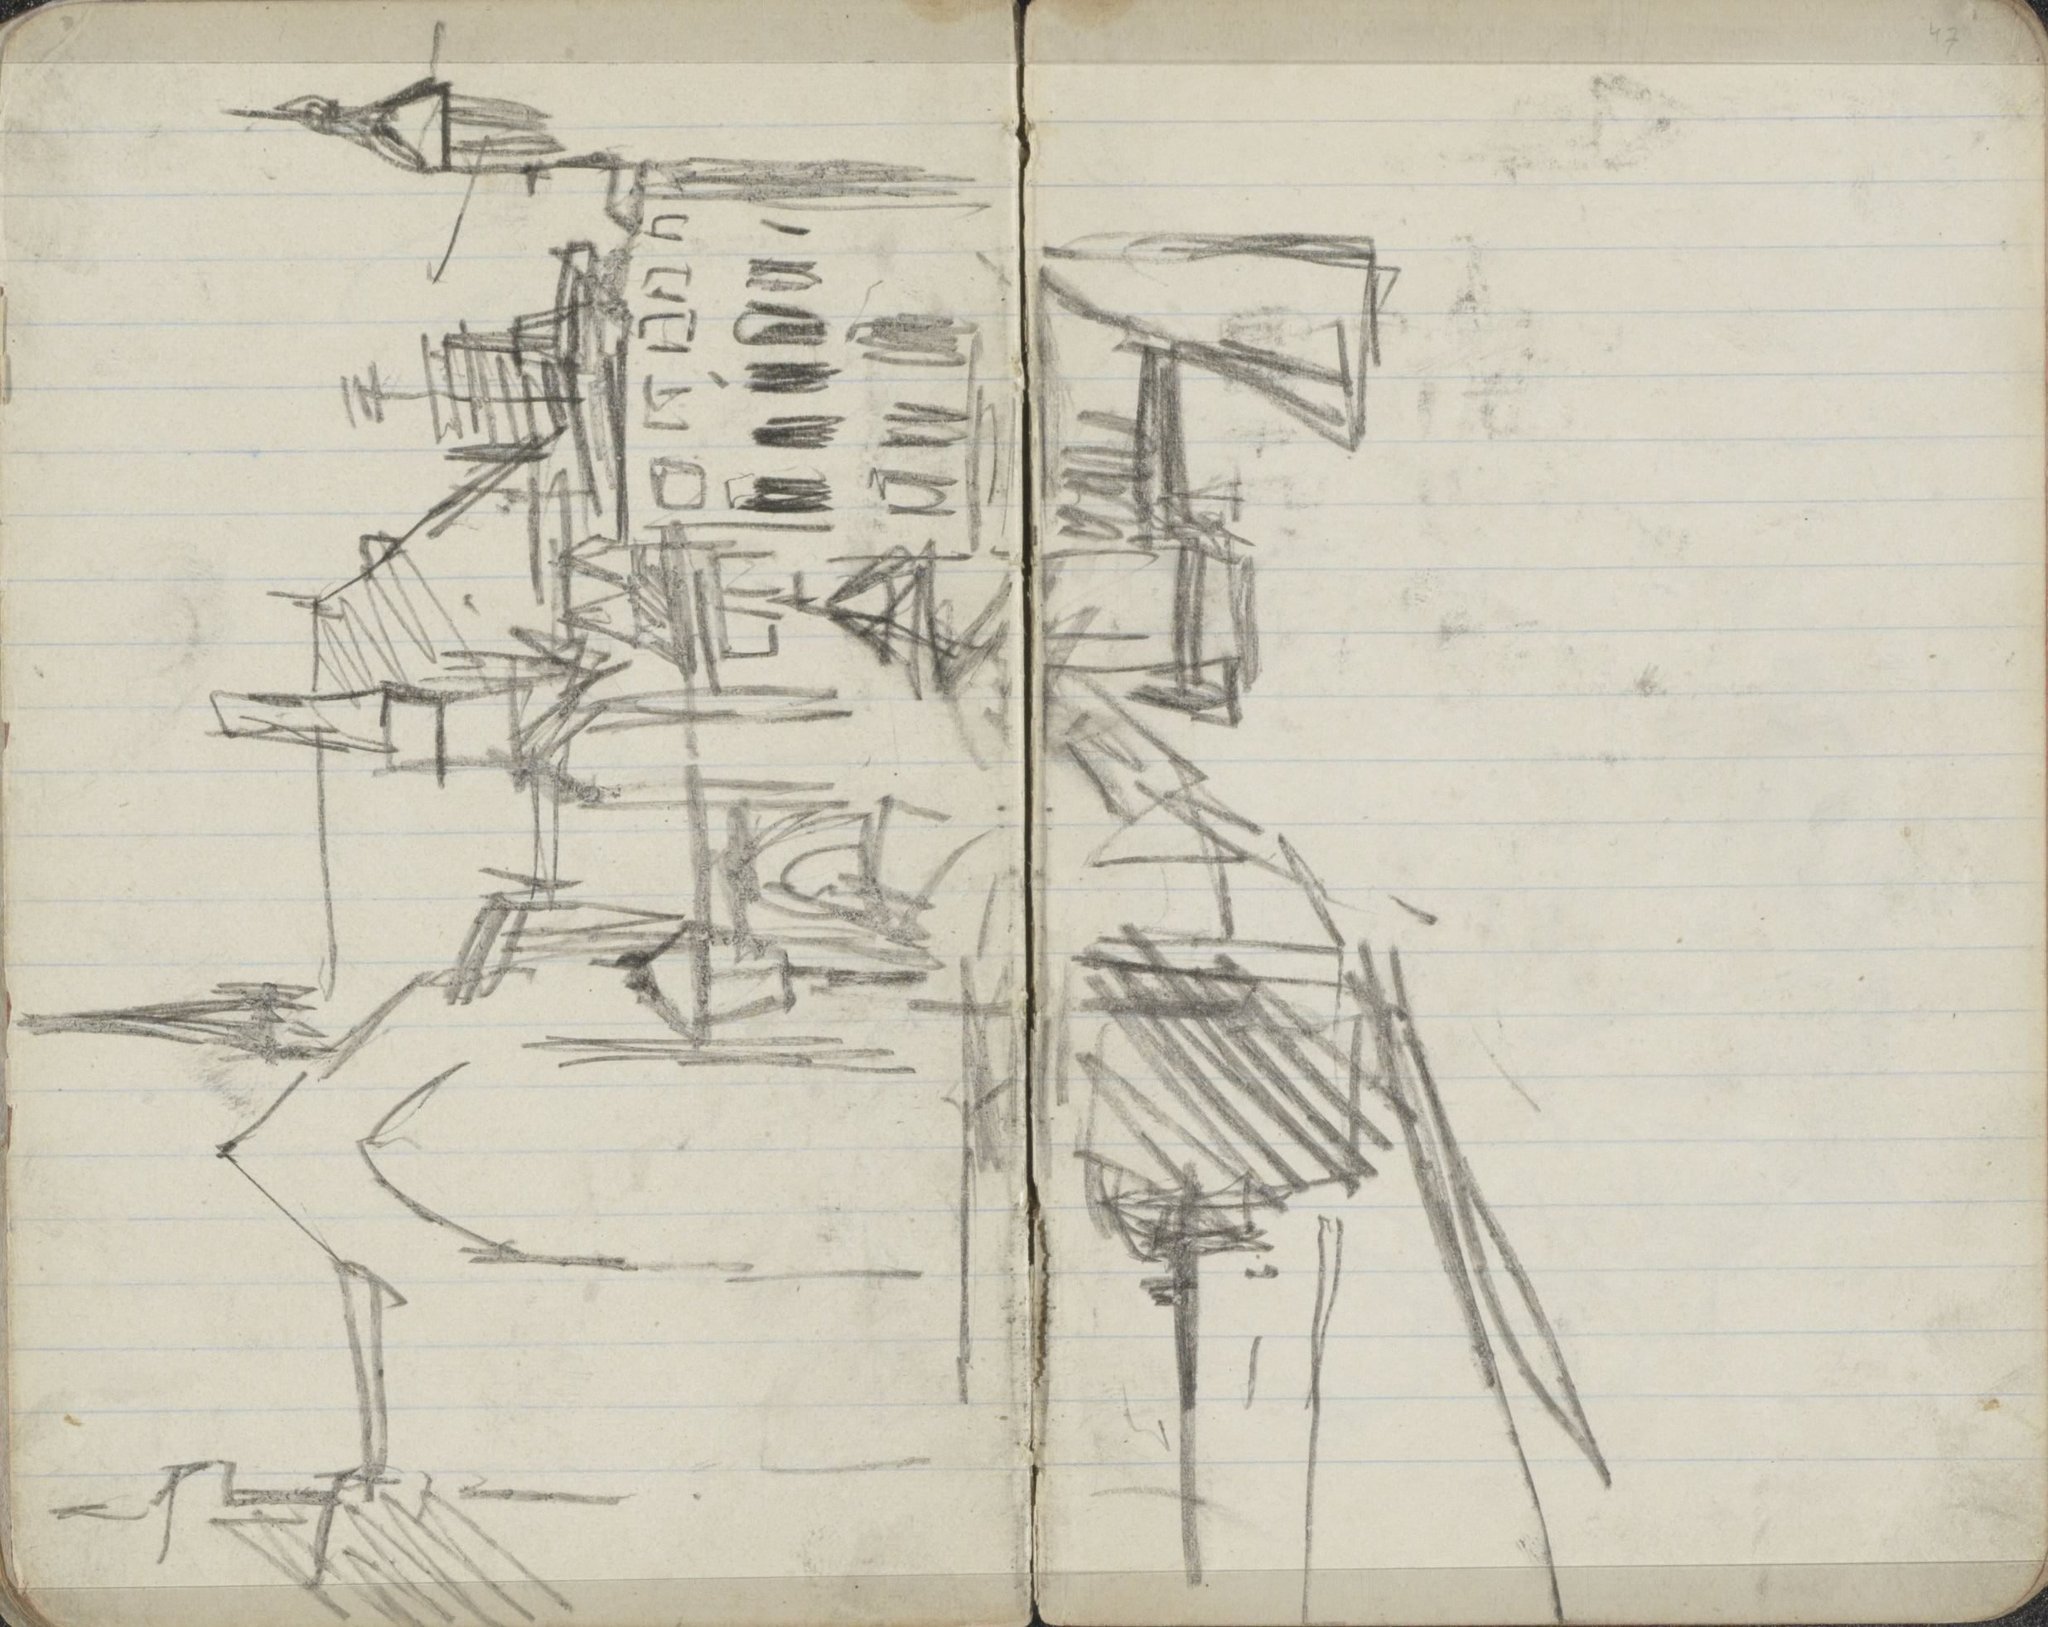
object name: sketchbook leaf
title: Gezicht op de Dam te Amsterdam met de Nieuwe Kerk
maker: george hendrik breitner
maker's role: draughtsman, painter, print maker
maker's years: 1857-1923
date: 1893-1894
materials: chalk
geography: amsterdam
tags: square, place, circus, etc., church (exterior), civic architecture; edifices; dwellings, royal palace of amsterdam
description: Links het Koninklijk Paleis. Pagina 46 en pagina 47 uit een schetsboek met 36 bladen.